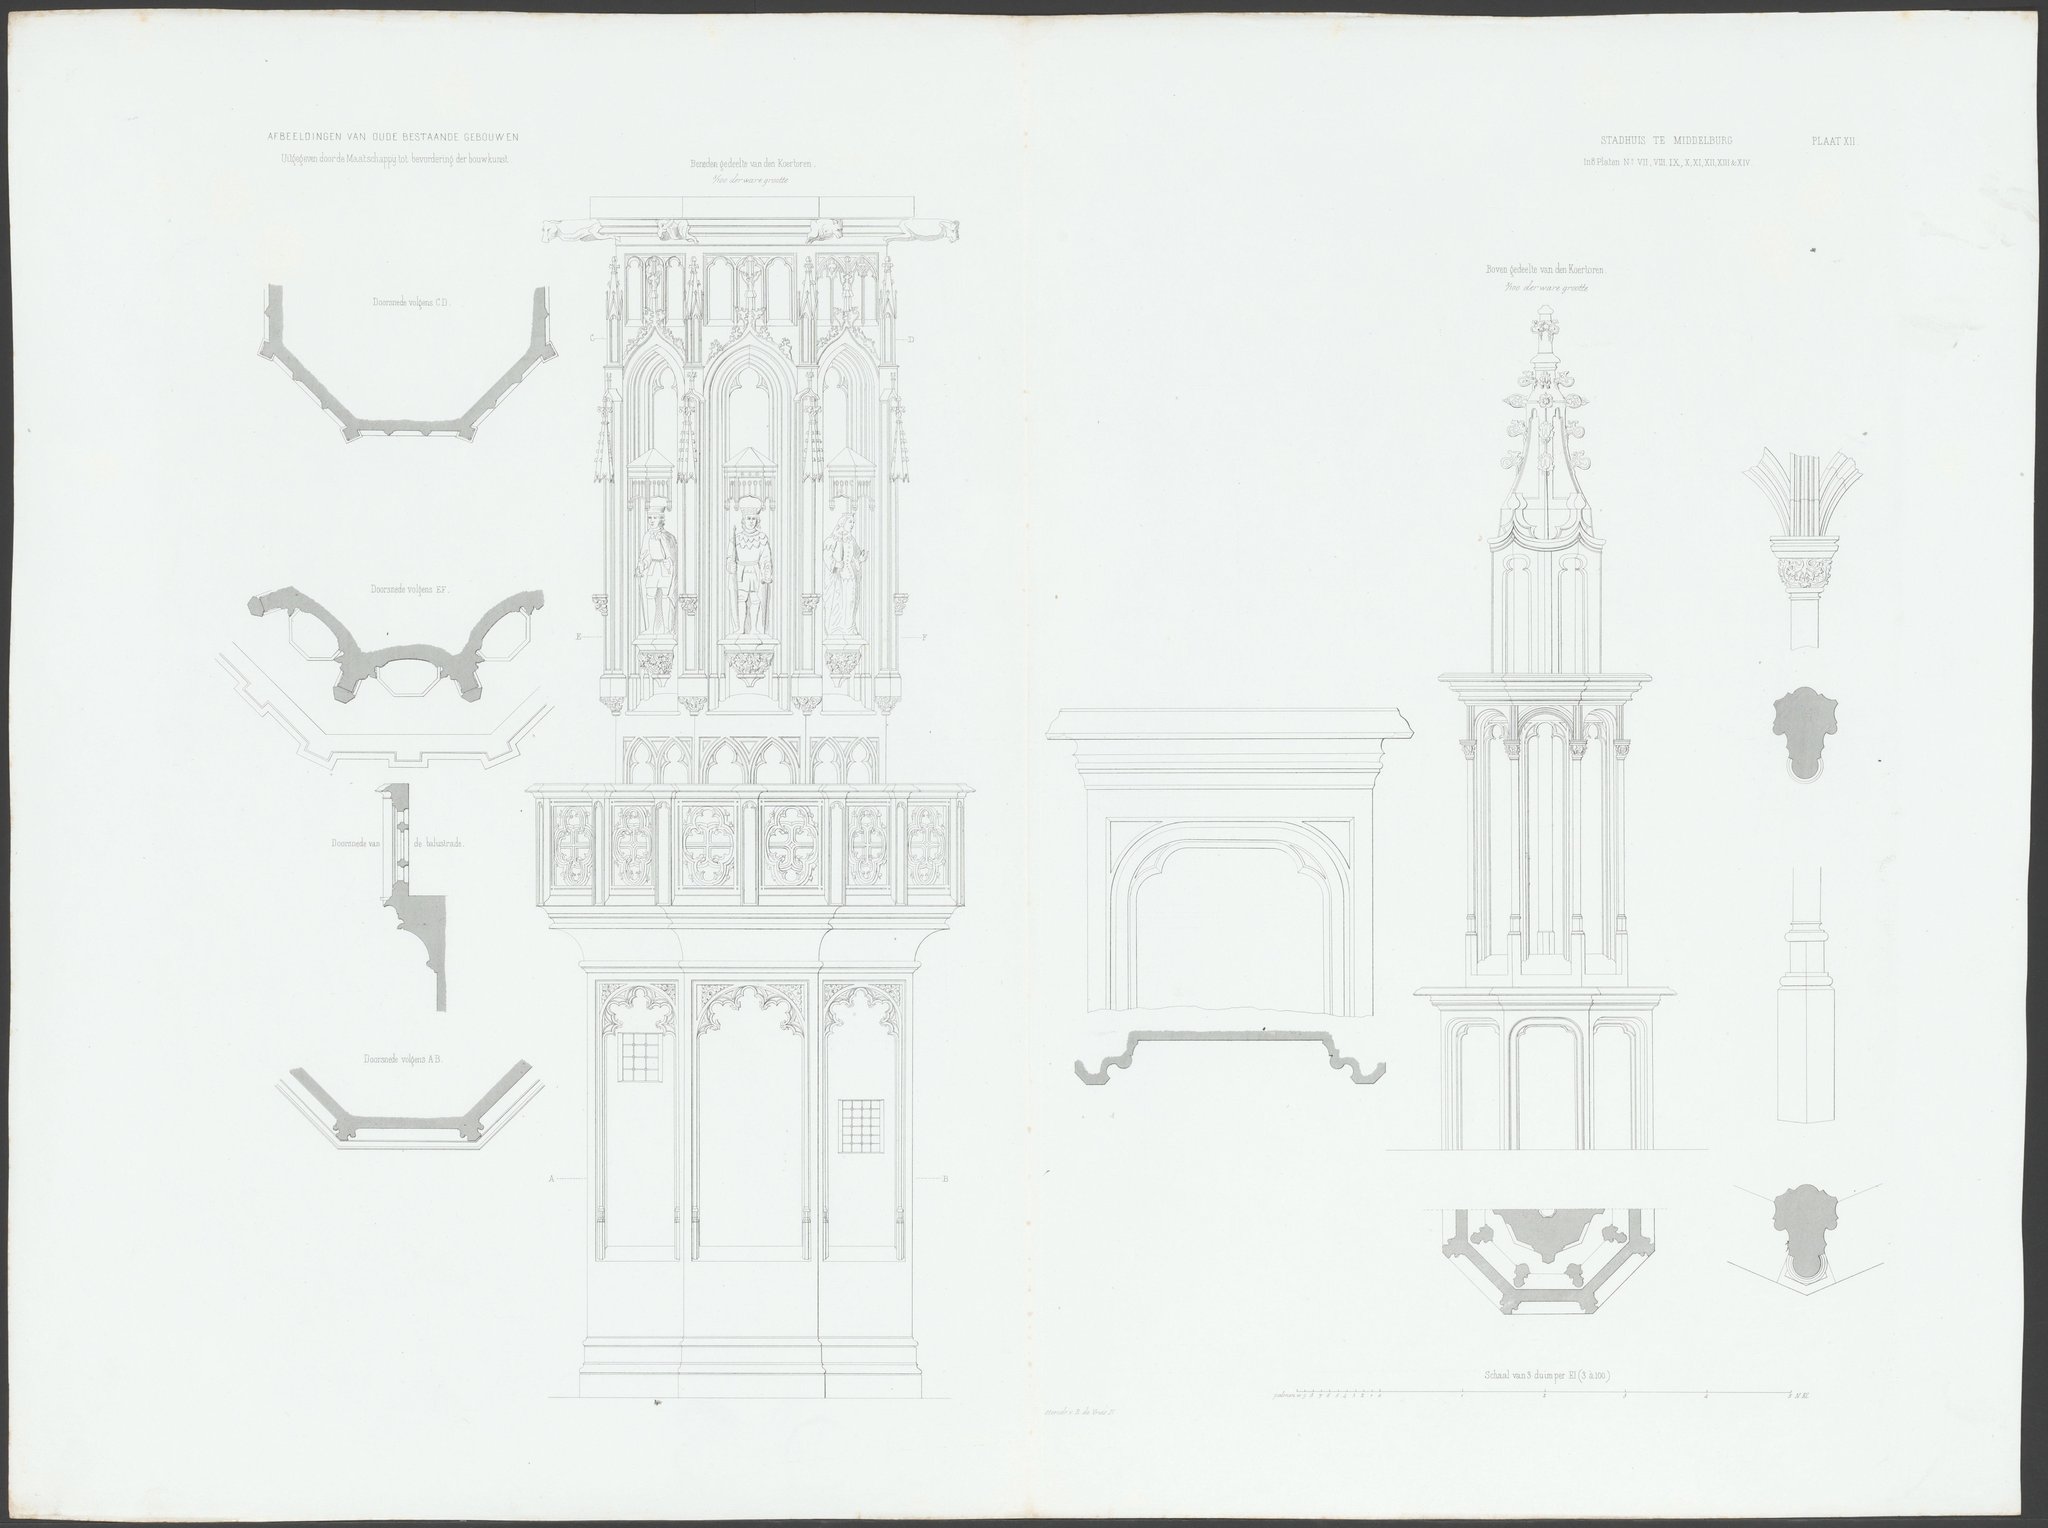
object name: print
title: Stadhuis te Middelburg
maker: ruurt de vries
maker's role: print maker, printer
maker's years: 1813-1874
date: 1854-1907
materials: paper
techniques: lithograph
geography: netherlands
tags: architectural detail, townhall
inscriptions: collector's mark: Lugt 1641, collector's mark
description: Delen van de Koertoren van het stadhuis van Middelburg. Onderaan een schaalstok. Dubbelgevouwen blad. Architectuurvoorstelling. Plaat XII. Onderwerpsrubrieken binnen de Atlas Zeden en Gewoonten: Regeering, Stadhuizen (H-M).